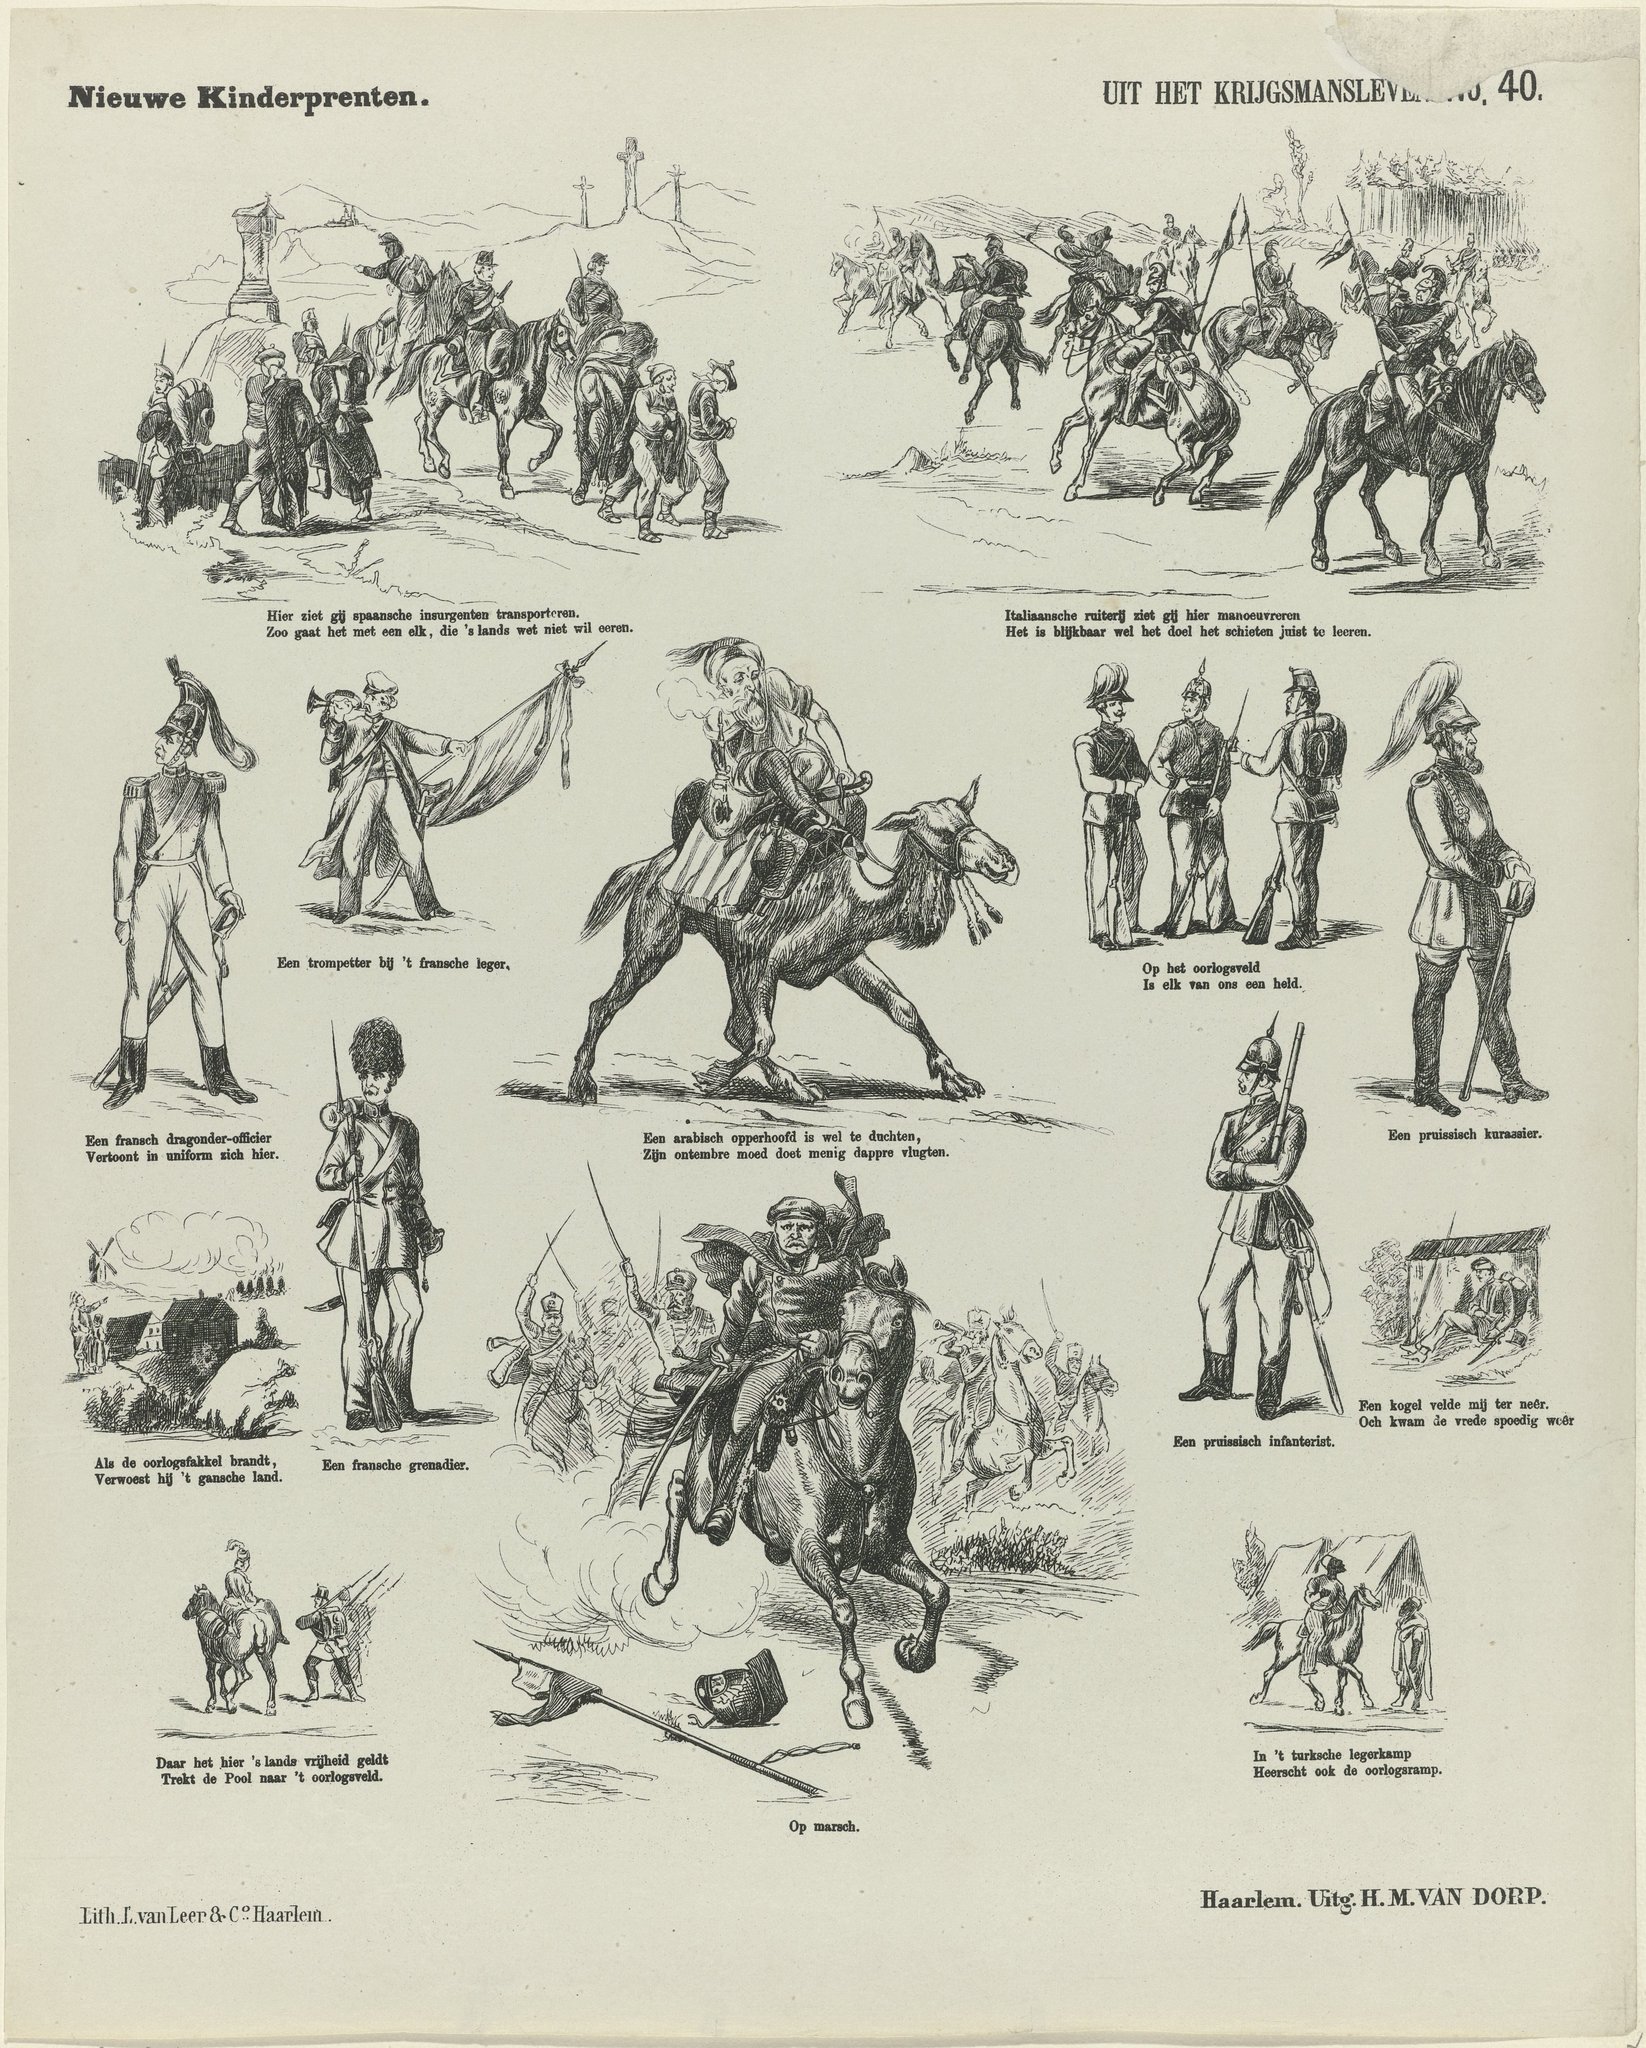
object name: popular print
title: Uit het krijgsmansleven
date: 1872-1883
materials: paper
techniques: letterpress printing, lithograph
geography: haarlem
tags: the soldier; the soldier's life, (military) uniforms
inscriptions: collector's mark: Lugt 2760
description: Blad met 14 voorstellingen over soldaten, waaronder soldaten uit verschillende landen en in verschillende uniformen, de ruiterij, een legerkamp en een gewonde soldaat. Onder elke afbeelding een onderschrift. Genummerd rechtsboven: No. 40.